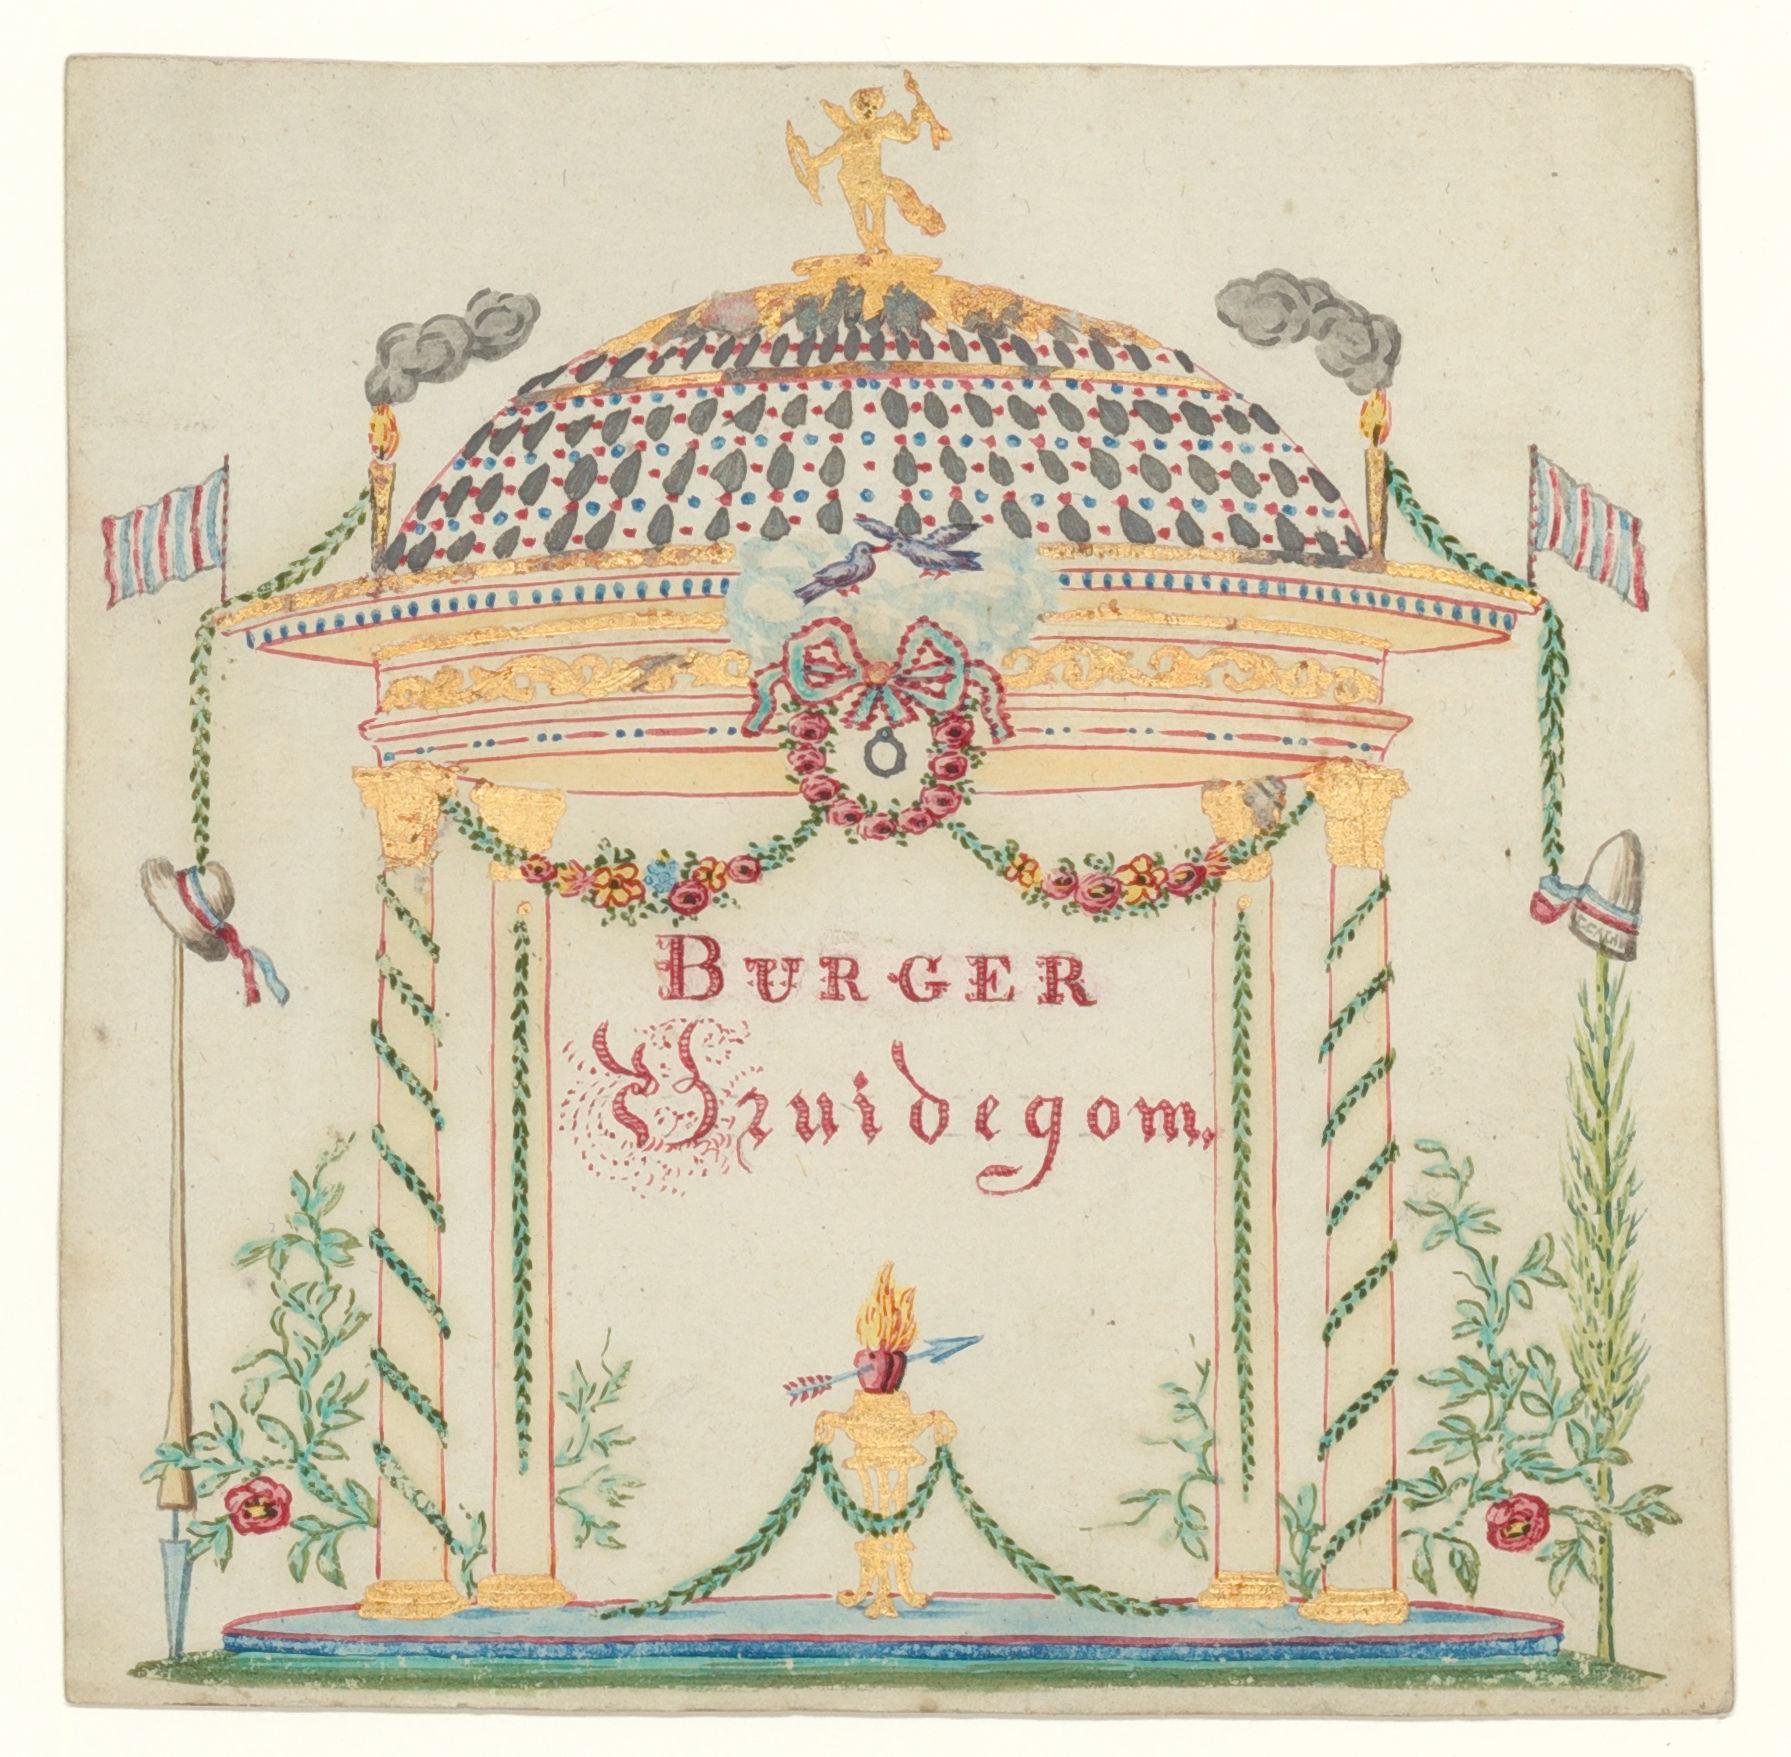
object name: print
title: Naamkaartje voor de 'Burger Bruidegom'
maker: Anonymous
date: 1795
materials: paint, paper, watercolor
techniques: brush, calligraphy, pen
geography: netherlands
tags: wedding feast, wedding meal, freedom, liberty; 'libertà' (ripa)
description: Naamkaartje voor de 'Burger Bruidegom', te gebruiken bij de tafelindeling bij een bruilofts- of andere feestmaal. Tempel met huwelijkssymboliek en de vrijheidshoed op een lans. Mogelijk onderdeel van een groep van bruilofts- en invitatiekaartjes van de families Bernard en Metayer. Onderwerpsrubrieken binnen de Atlas Zeden en Gewoonten: Des Menschen Begin, Midden en Einde. Bruiloft en huwelijk.